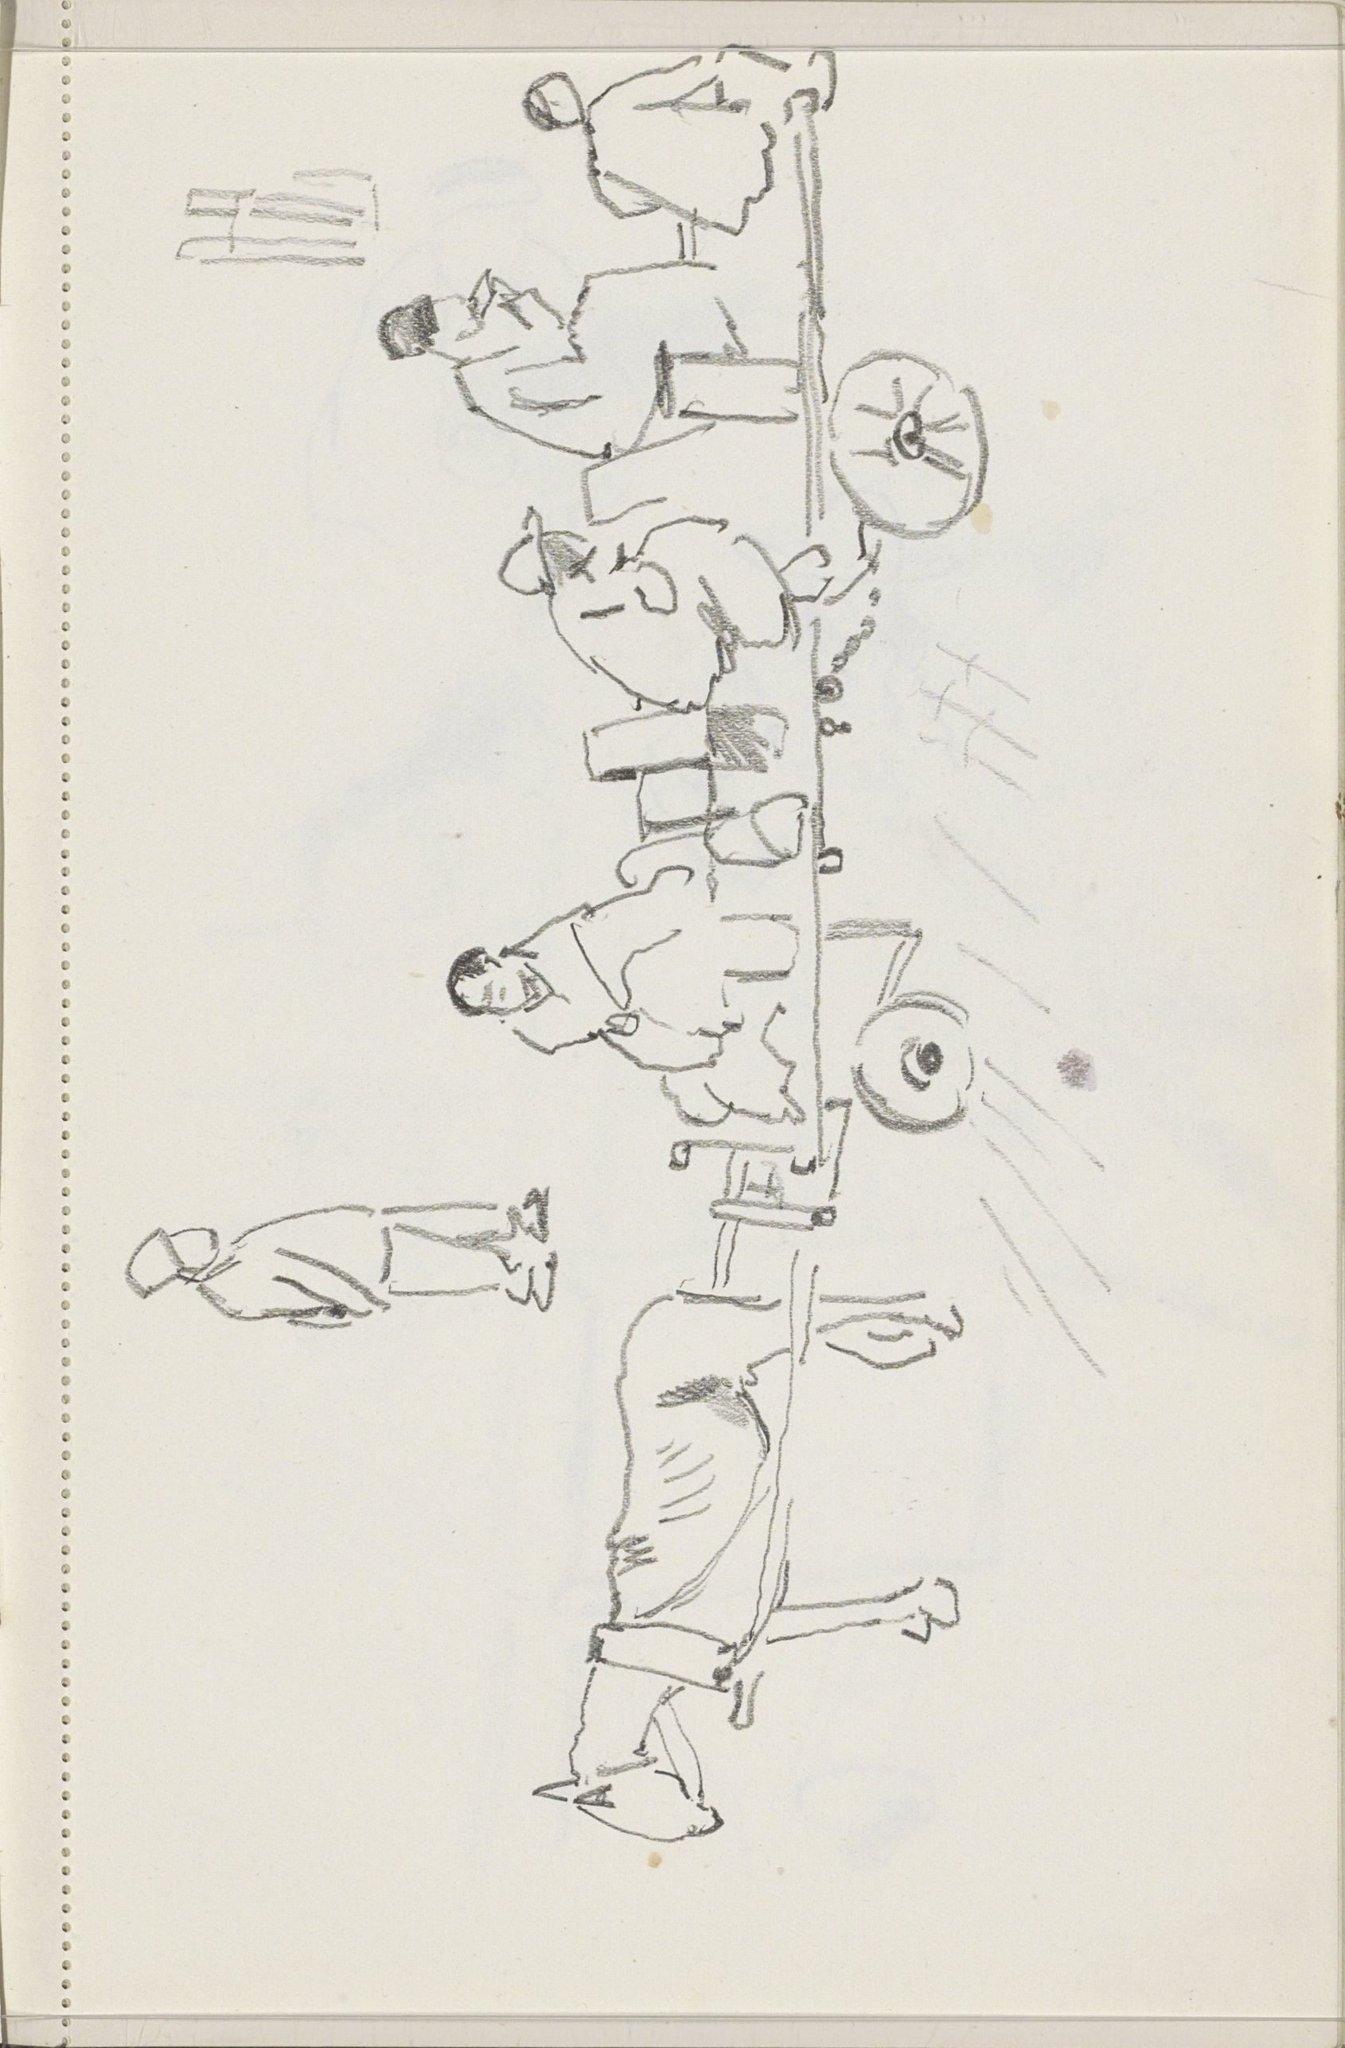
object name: sketchbook leaf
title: Zittende figuren en bagage op een paardenkar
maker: cornelis vreedenburgh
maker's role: draughtsman, print maker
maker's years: 1880-1946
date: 1936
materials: paper, pencil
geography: maghreb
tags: animal traction, animal-drawn vehicle (carriage etc.), horse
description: De figuren zitten en koffers staan op een langwerpige platte kar die door een paard wordt getrokken. Blad 26 recto uit een schetsboek met 73 bladen.